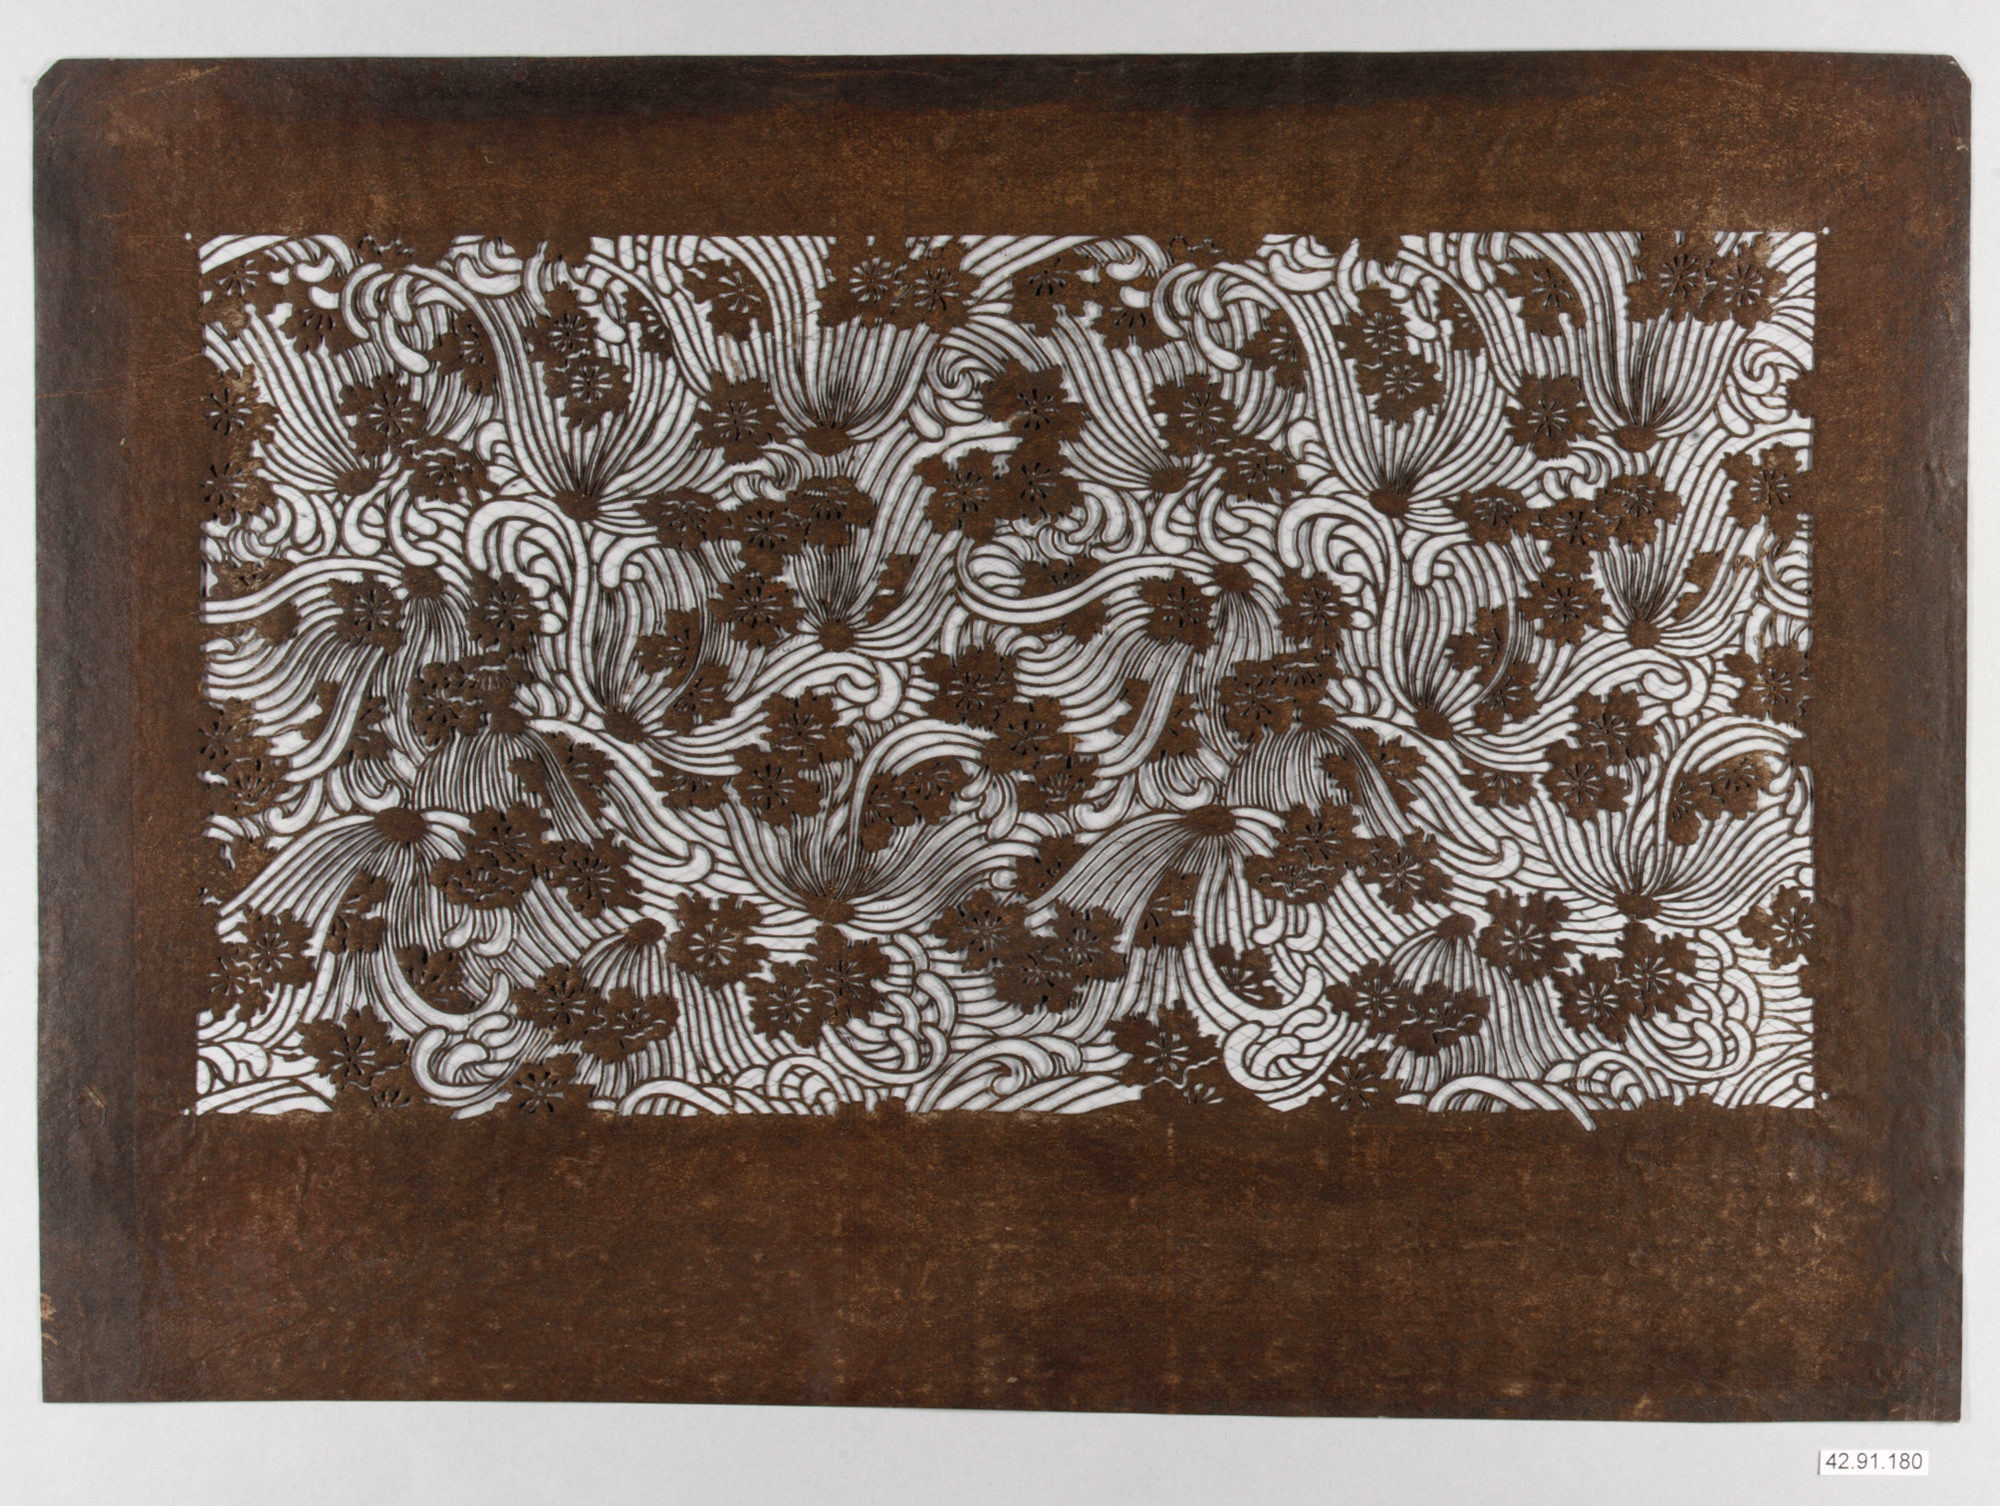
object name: stencil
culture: japanese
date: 1801-1900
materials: paper, silk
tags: flowers